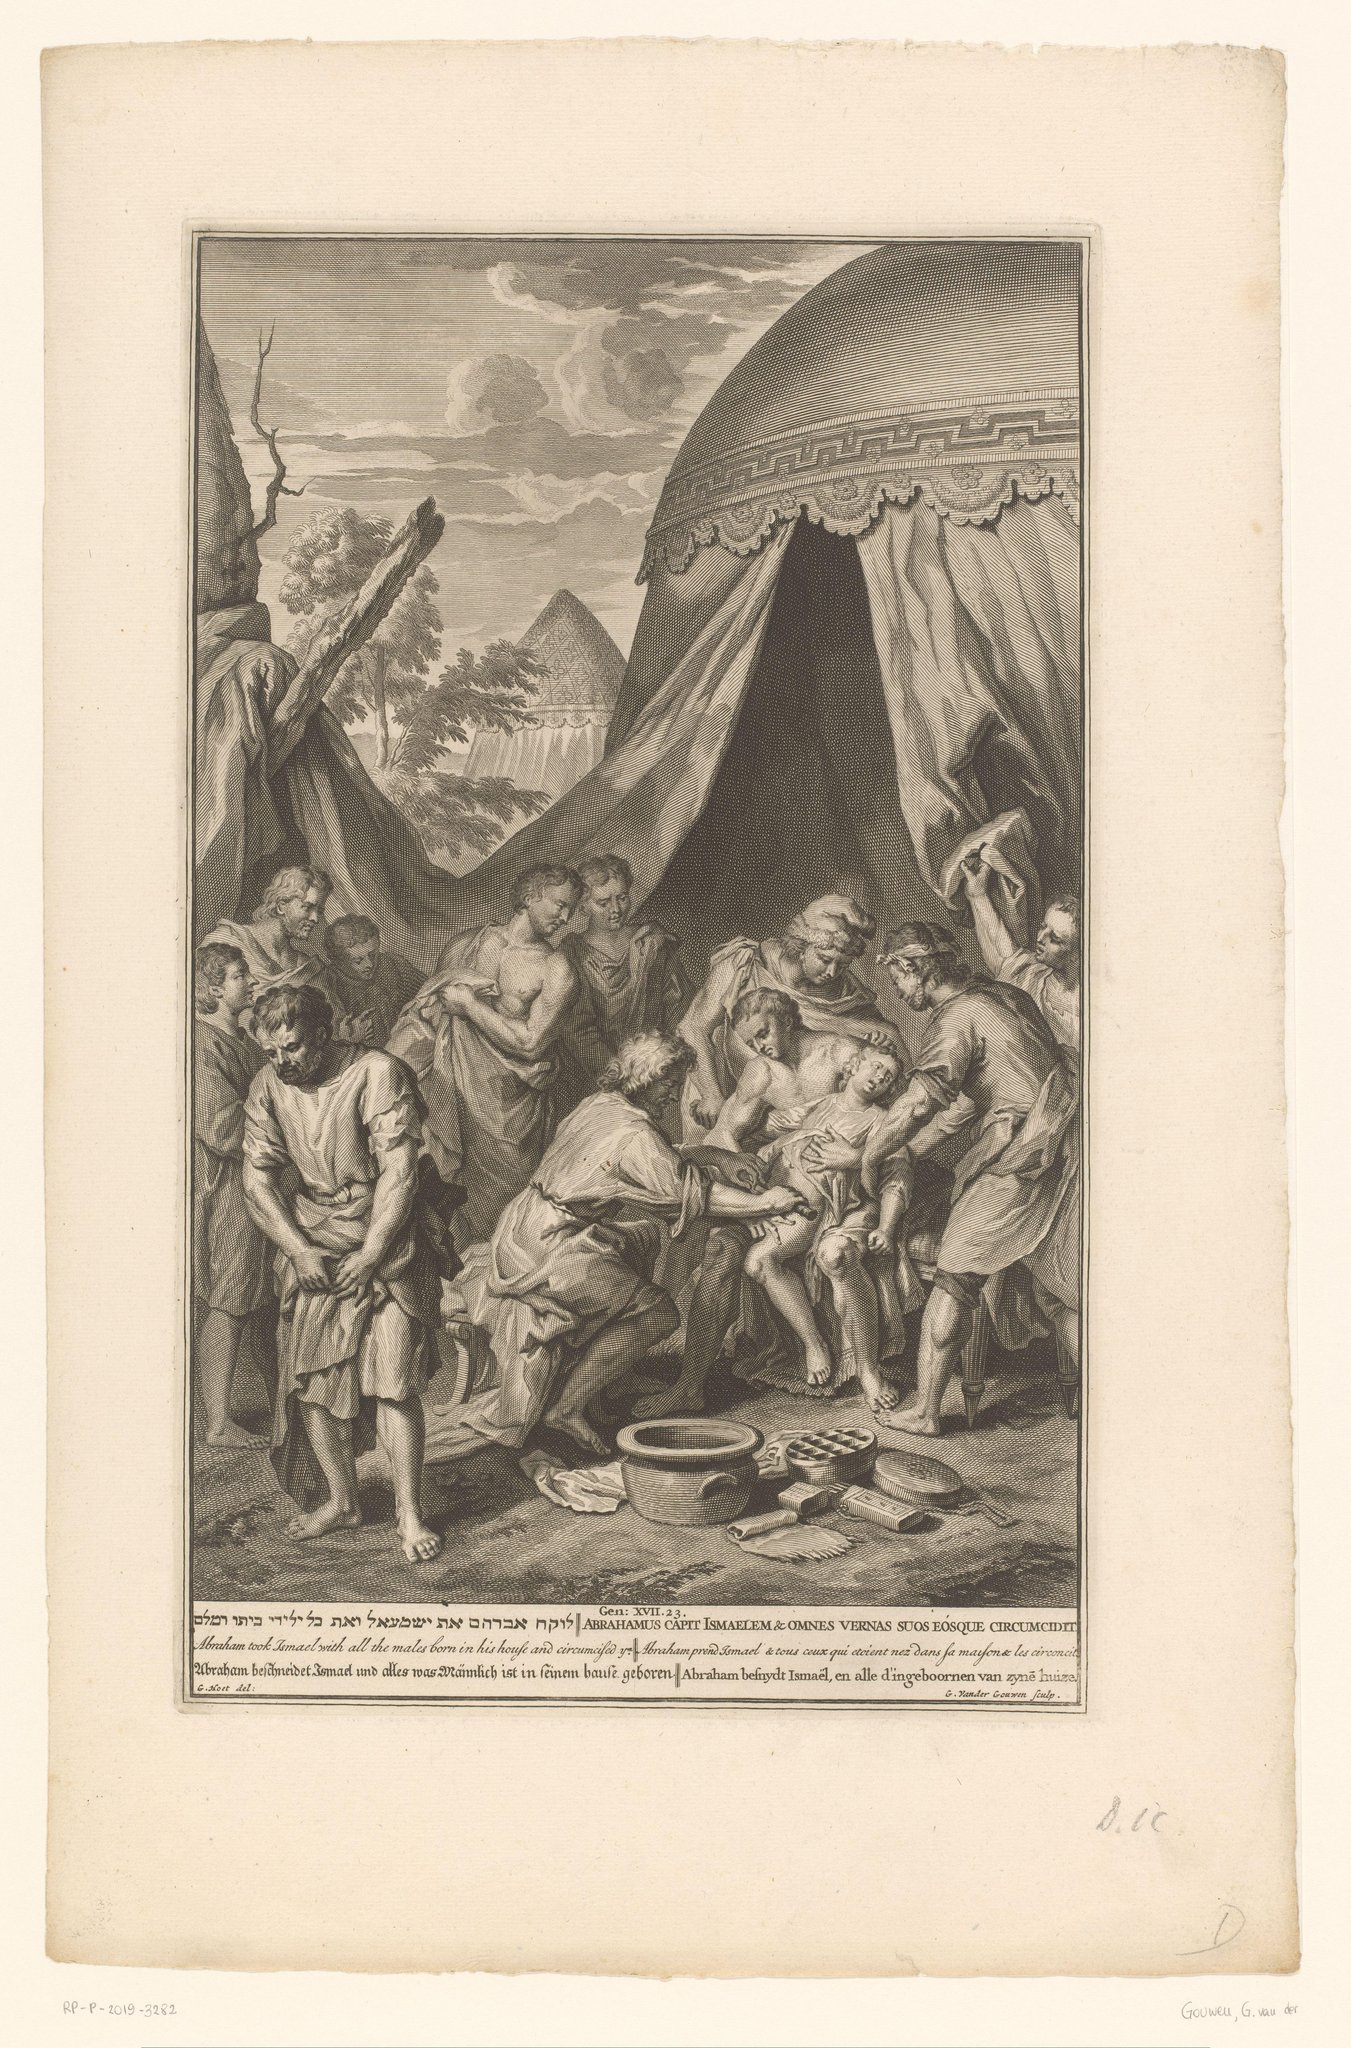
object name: print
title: Besnijdenis van Ismaël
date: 1720-1728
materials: paper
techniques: engraving, etching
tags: ishmael and all the men of the household are circumcised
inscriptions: inscription: ‘ütrechts Fündatie hüijs’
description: Prent gemaakt voor: Figures de la Bible. Amsterdam: Bernard Picart, 1720. Prent ook gebruikt in: Taferelen der voornaamste geschiedenissen van het Oude en Nieuwe Testament (...) door de vermaarde kunstenaars Hoet, Houbraken, en Picart getekent (...) en met beschrijvingen uitgebreid. Den Haag: Pieter de Hondt, 1728.